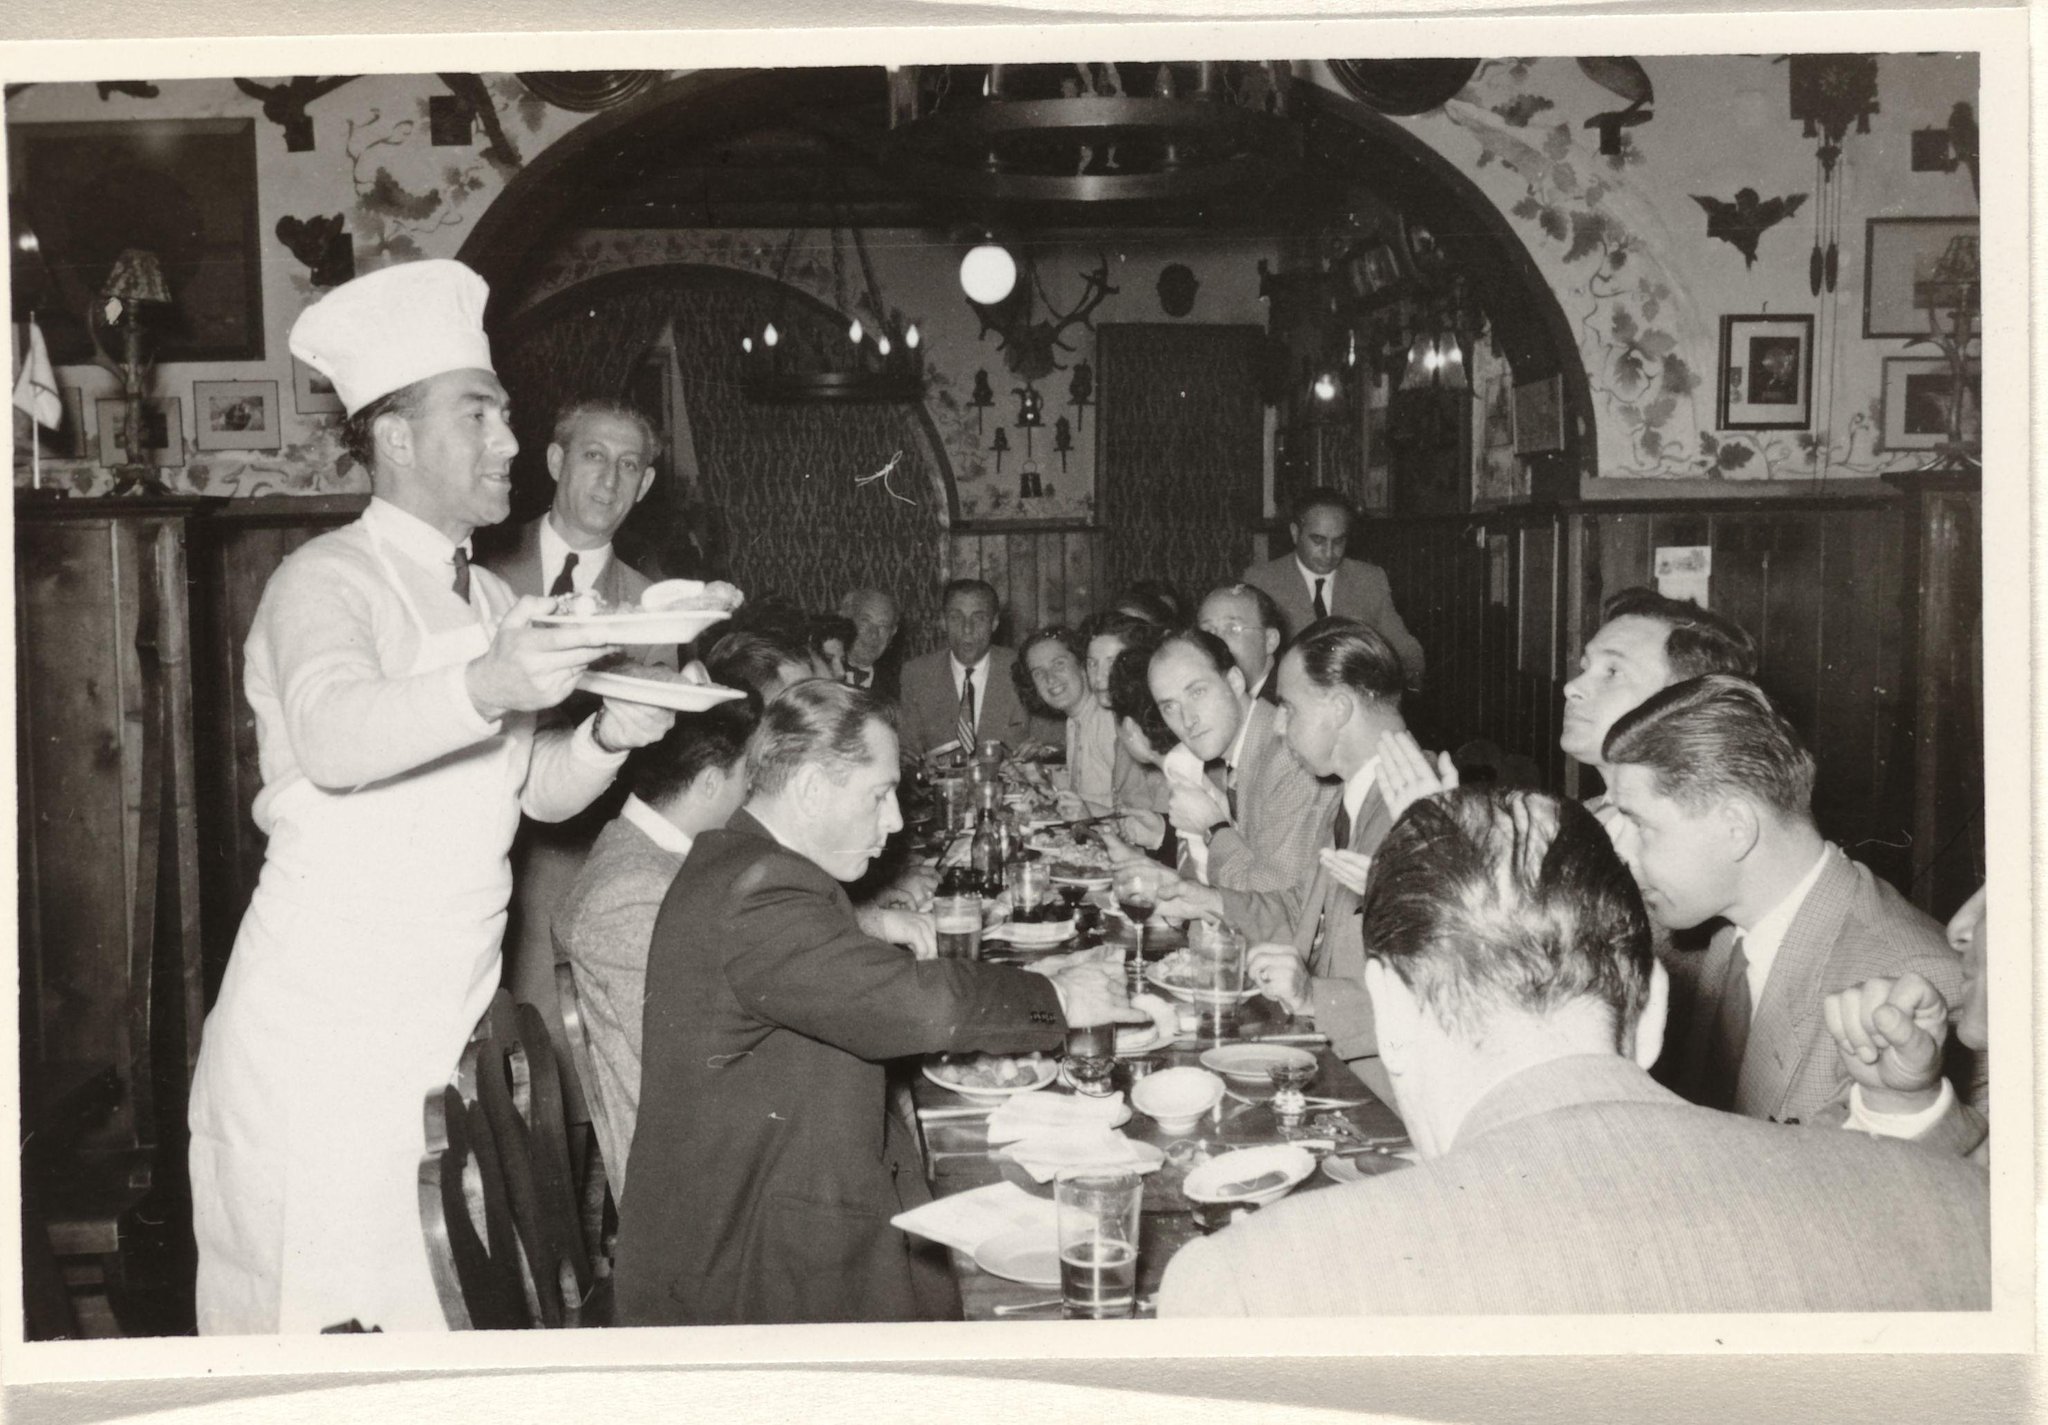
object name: photograph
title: Gezelschap van onbekende mensen gezeten aan een eettafel en etende, met een man in kokskleding die borden in zijn handen heeft, gezeten onder een boog met daarop bloemenbehang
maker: Anonymous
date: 1950-1970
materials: photographic support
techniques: gelatin silver print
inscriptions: number: ‘1925/6’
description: Gezelschap van onbekende mensen gezeten aan een eettafel en etende, met een man in kokskleding die borden in zijn handen heeft, gezeten onder een boog met daarop bloemenbehang.